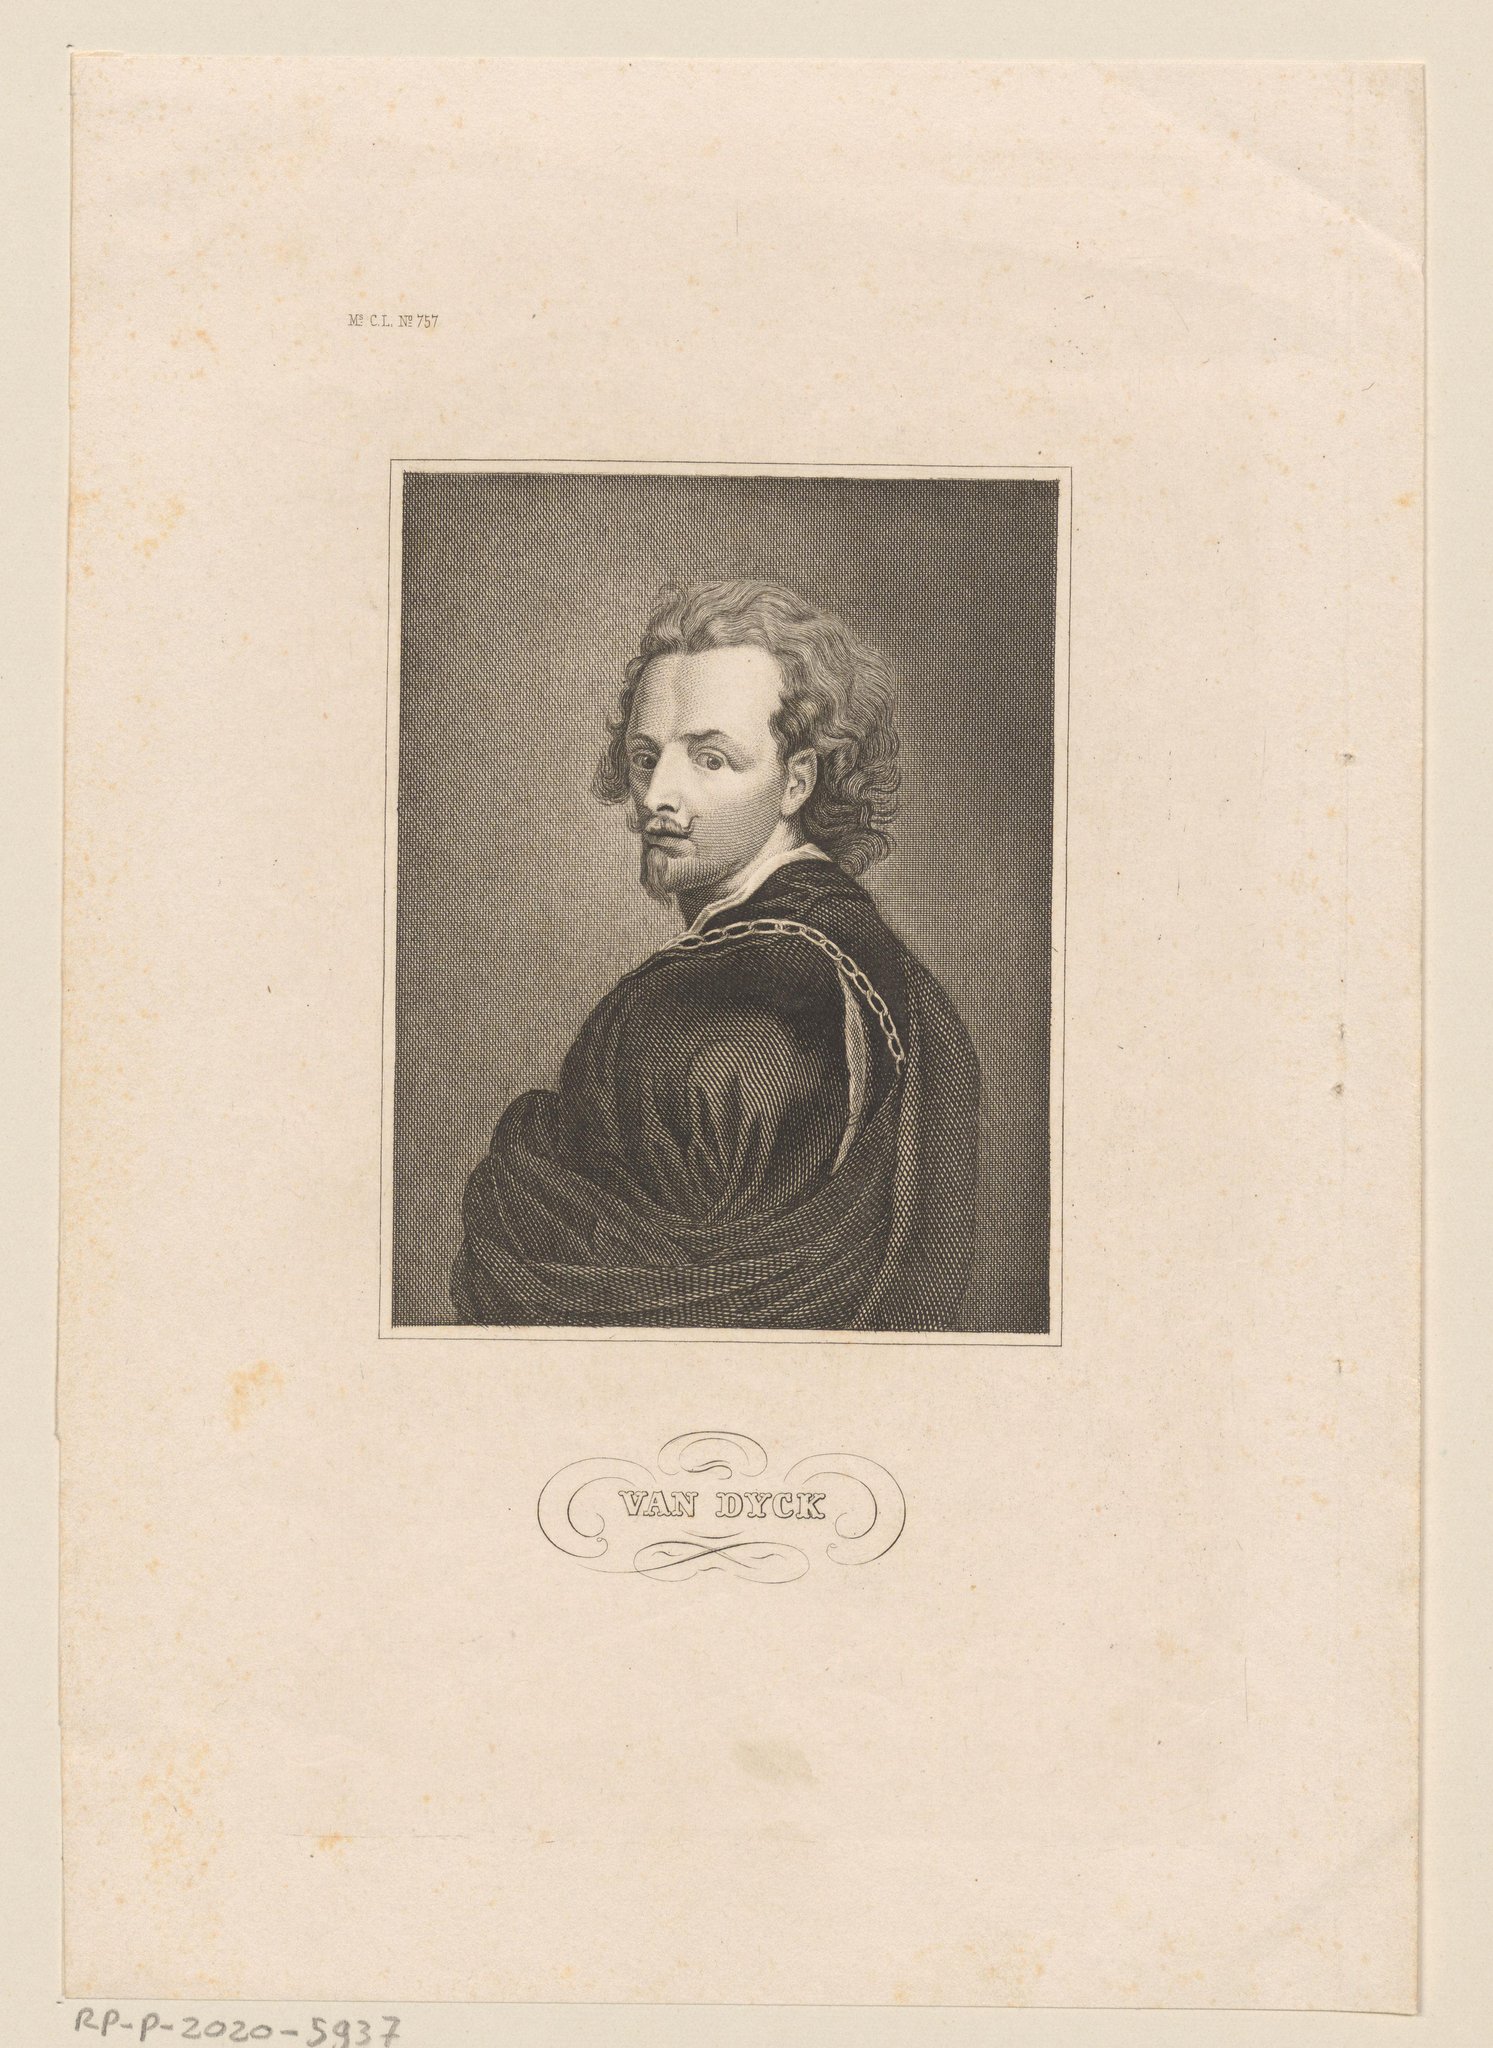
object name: print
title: Portret van Anthony van Dyck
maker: Anonymous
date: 1840-1855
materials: paper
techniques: engraving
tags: antwerp, london, painter, print maker, anthony van dyck, historical persons, portrait, self-portrait of painter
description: Prent waarschijnlijk uit: Meyer, Joseph. Das Grosse Conversations-Lexikon für die gebildeten Stände. Hildburghausen: Bibliographisches Institut, 1840-1855.